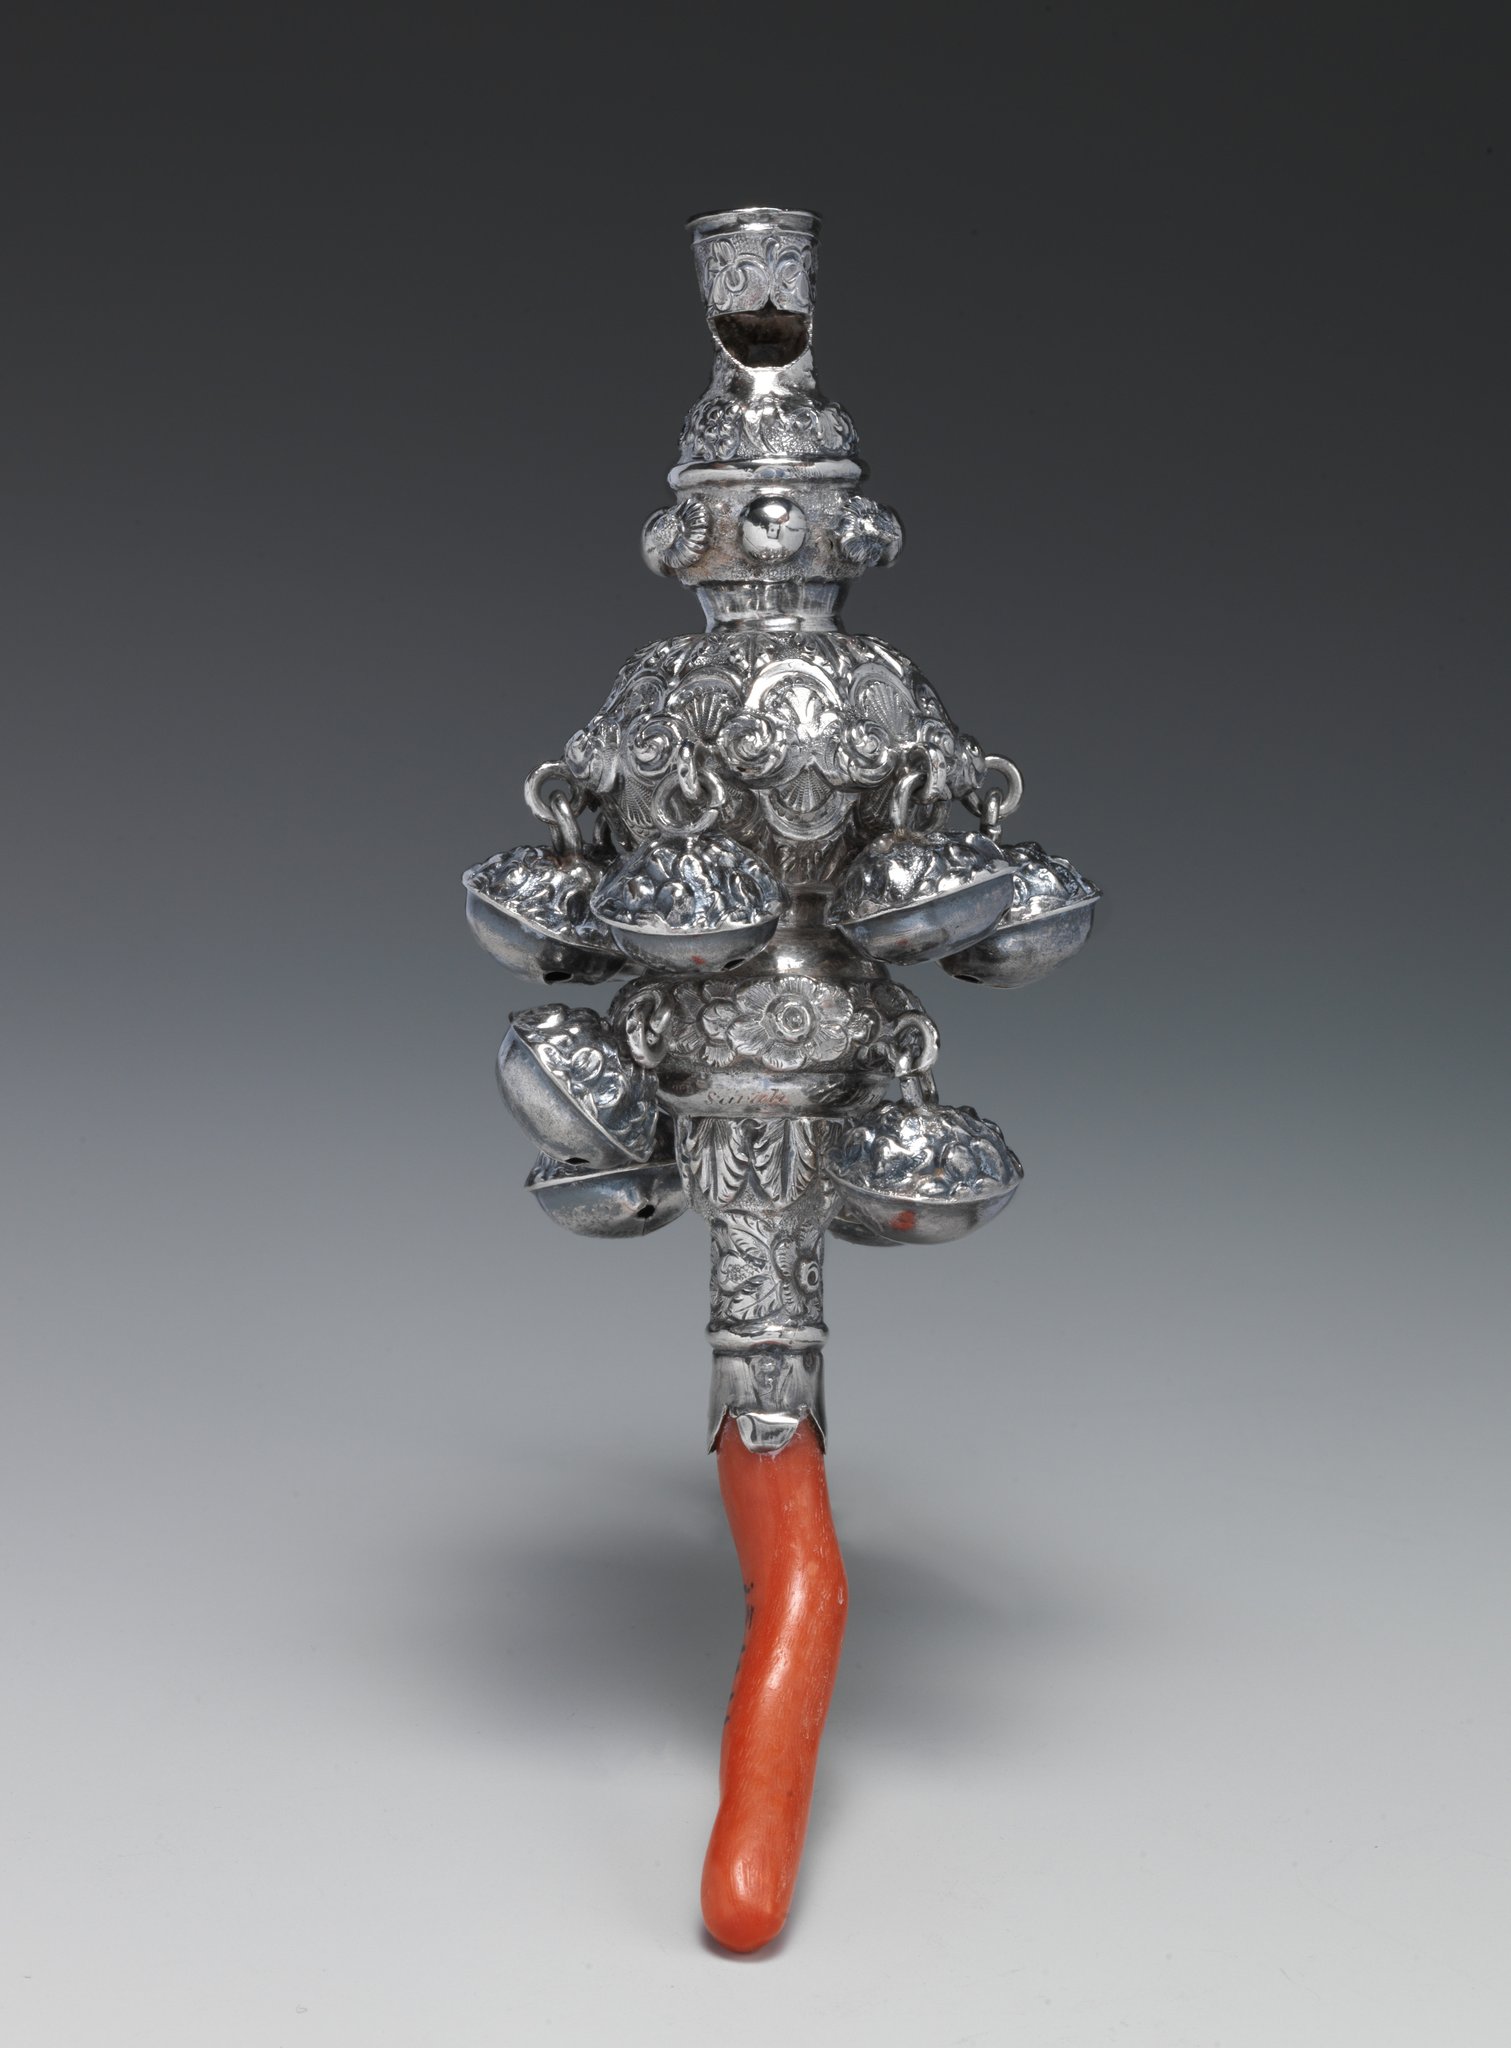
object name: rattle and teether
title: Child's rattle and teether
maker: g.u.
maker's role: maker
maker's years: 1785-1885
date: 1835-1836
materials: coral, silver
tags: amulets,toys